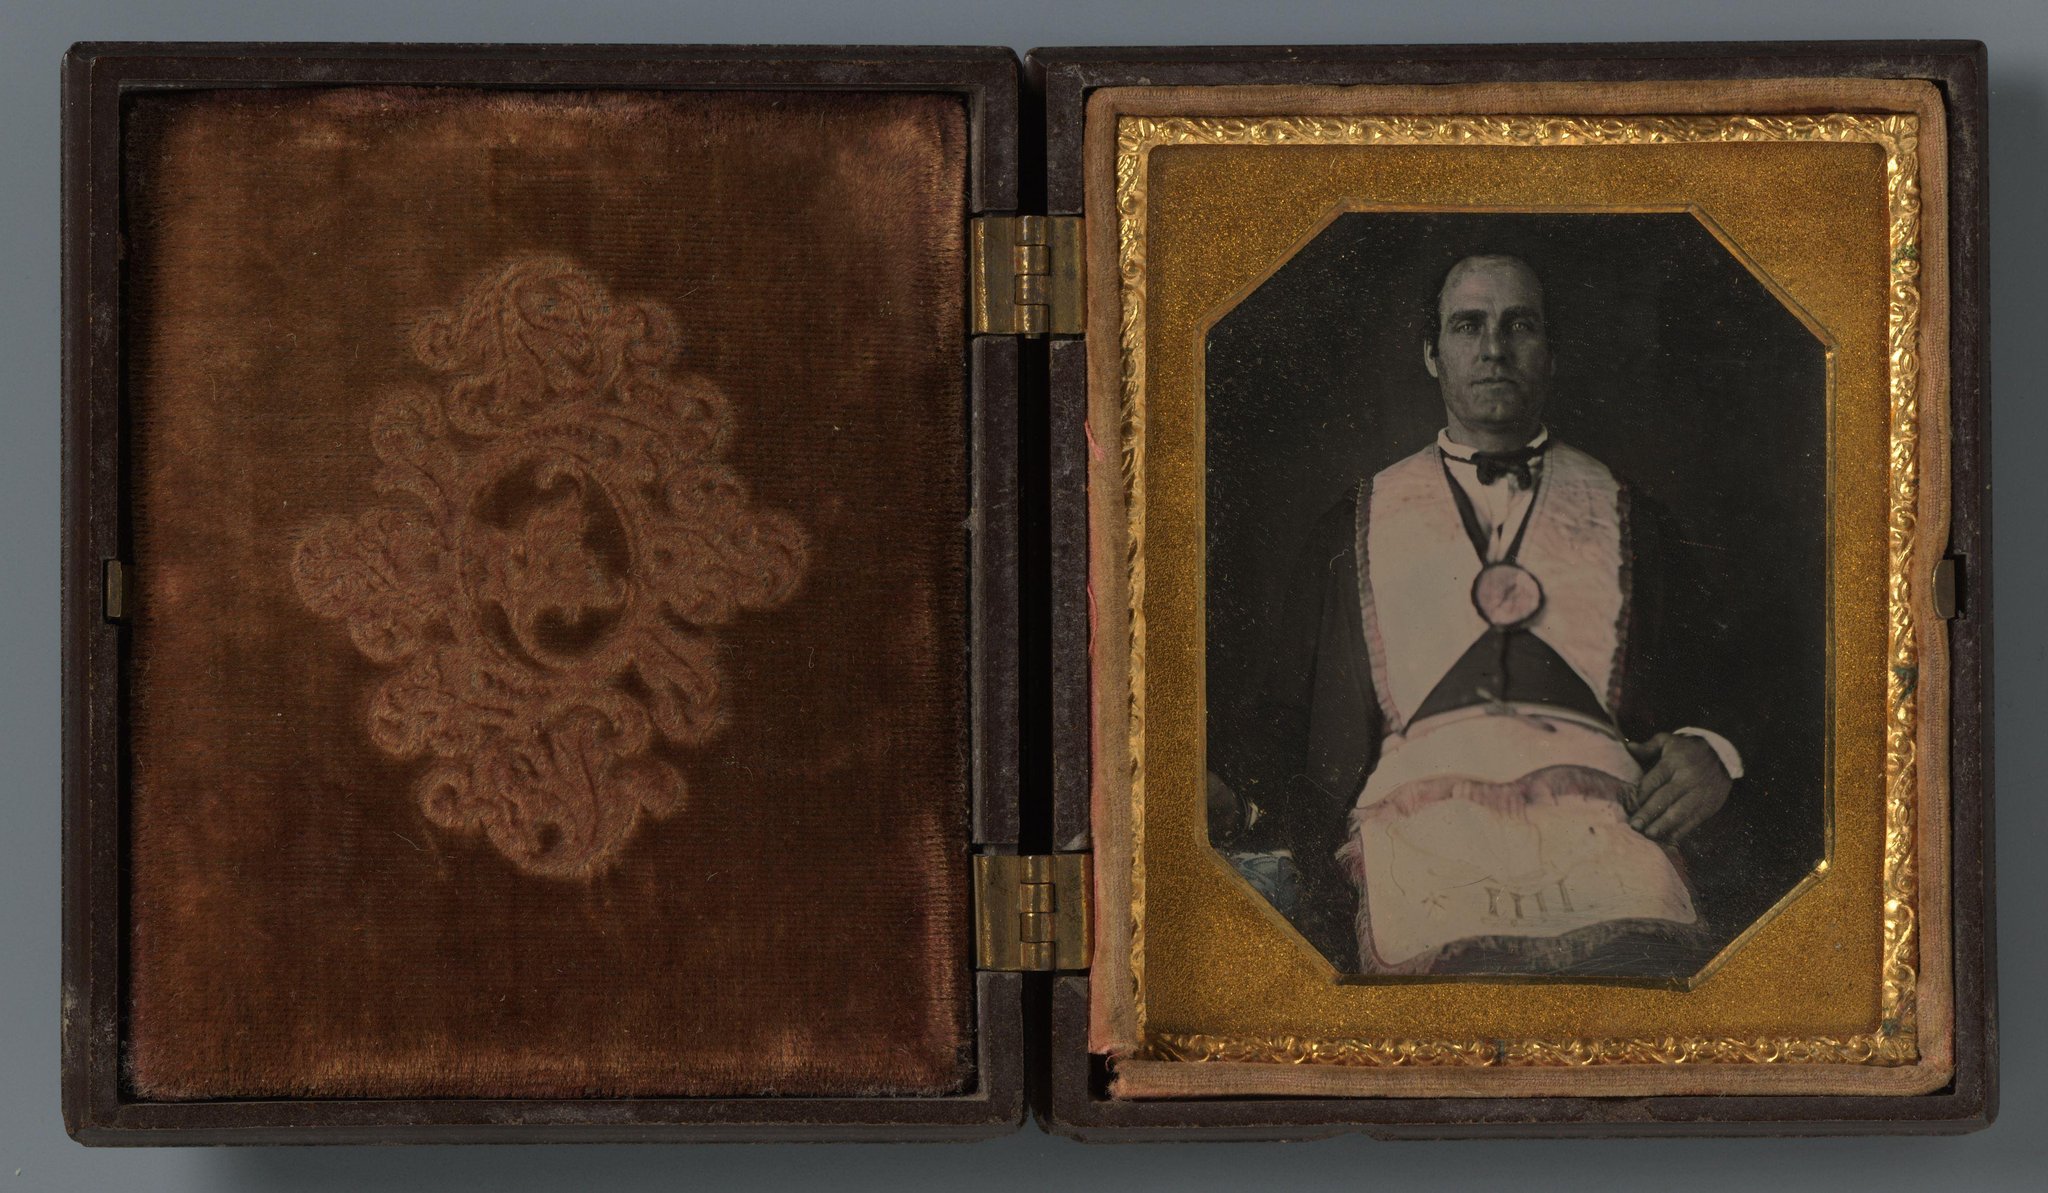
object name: photograph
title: Portret van een onbekende man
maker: Anonymous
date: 1840-1860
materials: copper, glass, plastic, velvet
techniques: daguerreotype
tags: adult man, historical persons